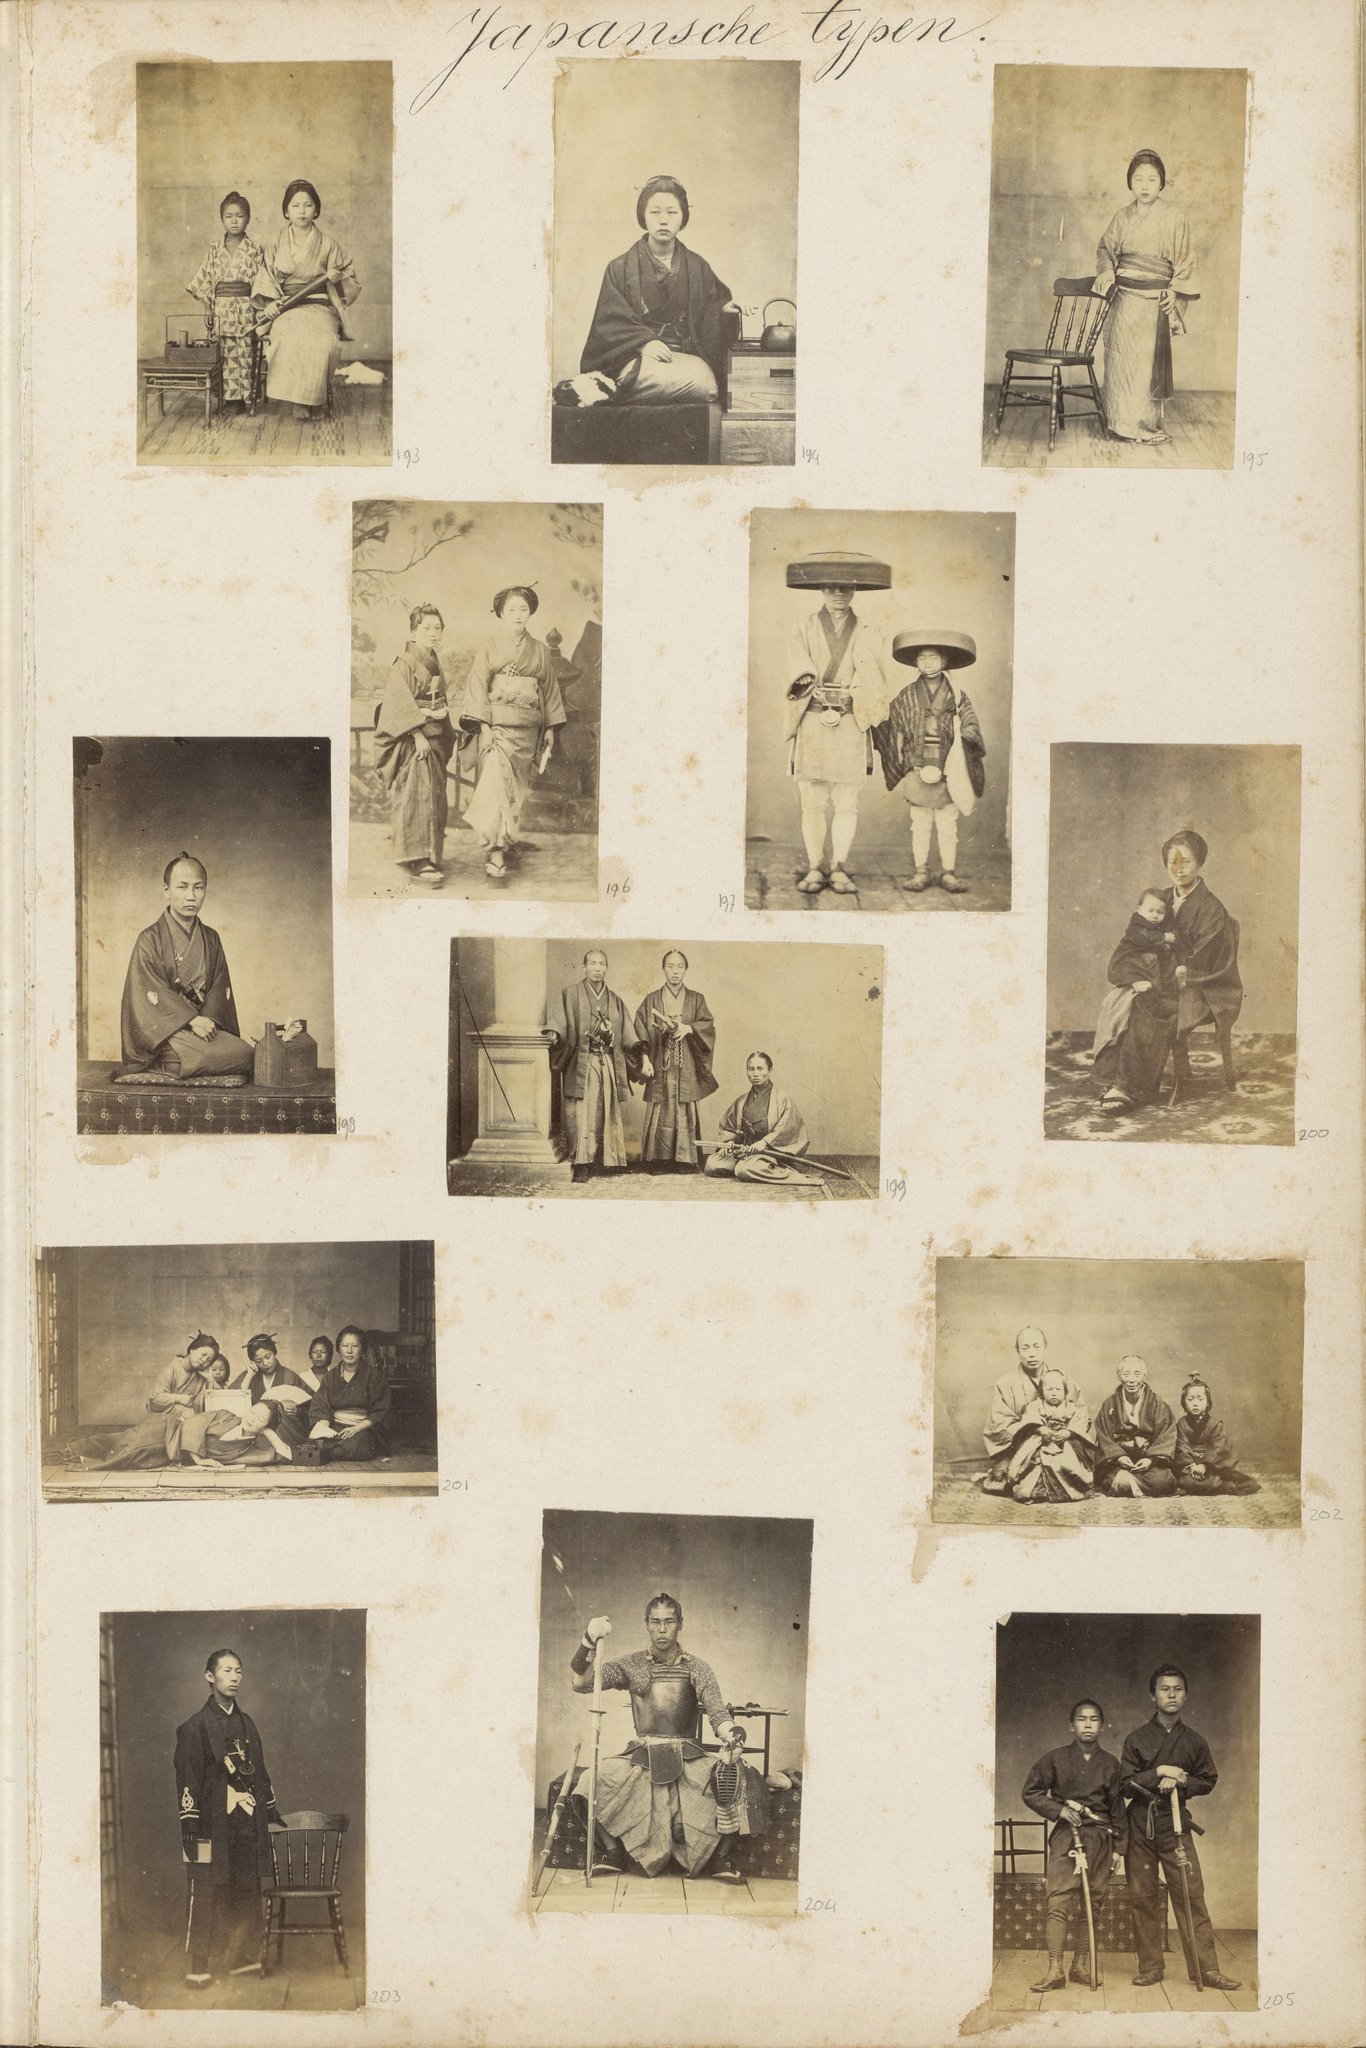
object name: photograph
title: Portret van een Japanse samoerai, zittend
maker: Anonymous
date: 1870-1880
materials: paper, photographic support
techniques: albumen print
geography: japan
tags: studio requisites ~ photographer, adult man, hacking and thrusting weapons: sword, (military) uniforms, japan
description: Onderdeel van Fotoalbum van Robert Daniel Crommelin (1841-1907).